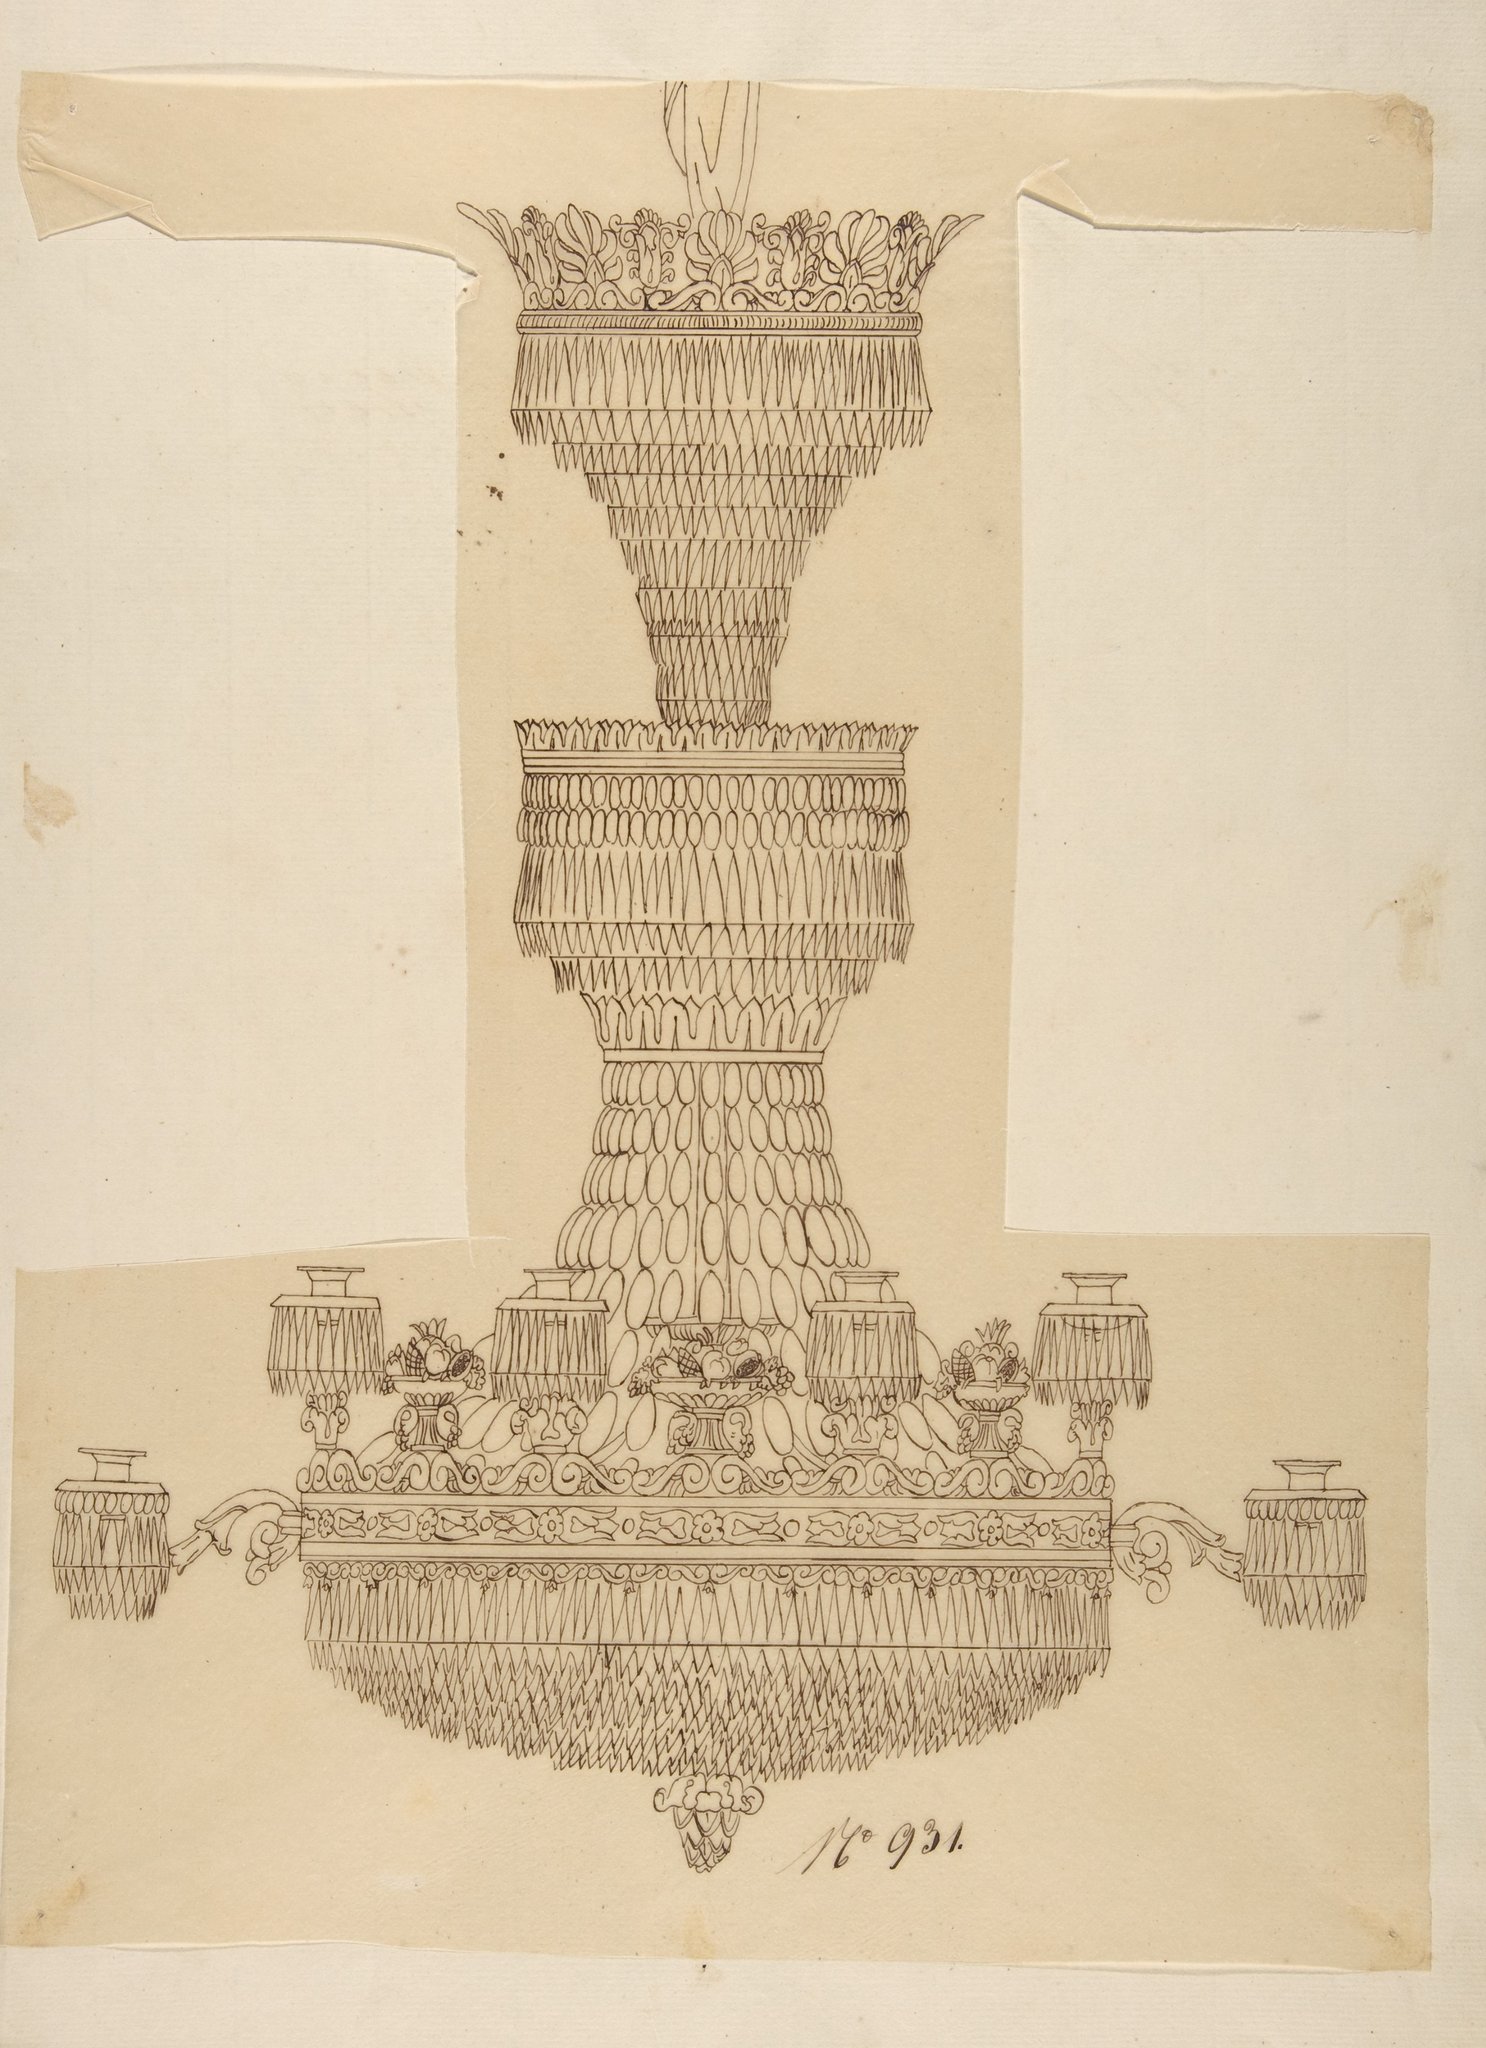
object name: drawing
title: Design for a Chandelier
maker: anonymous, french, 19th century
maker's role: artist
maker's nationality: french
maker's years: 1800-1900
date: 1801-1900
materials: ink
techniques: pen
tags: chandelier